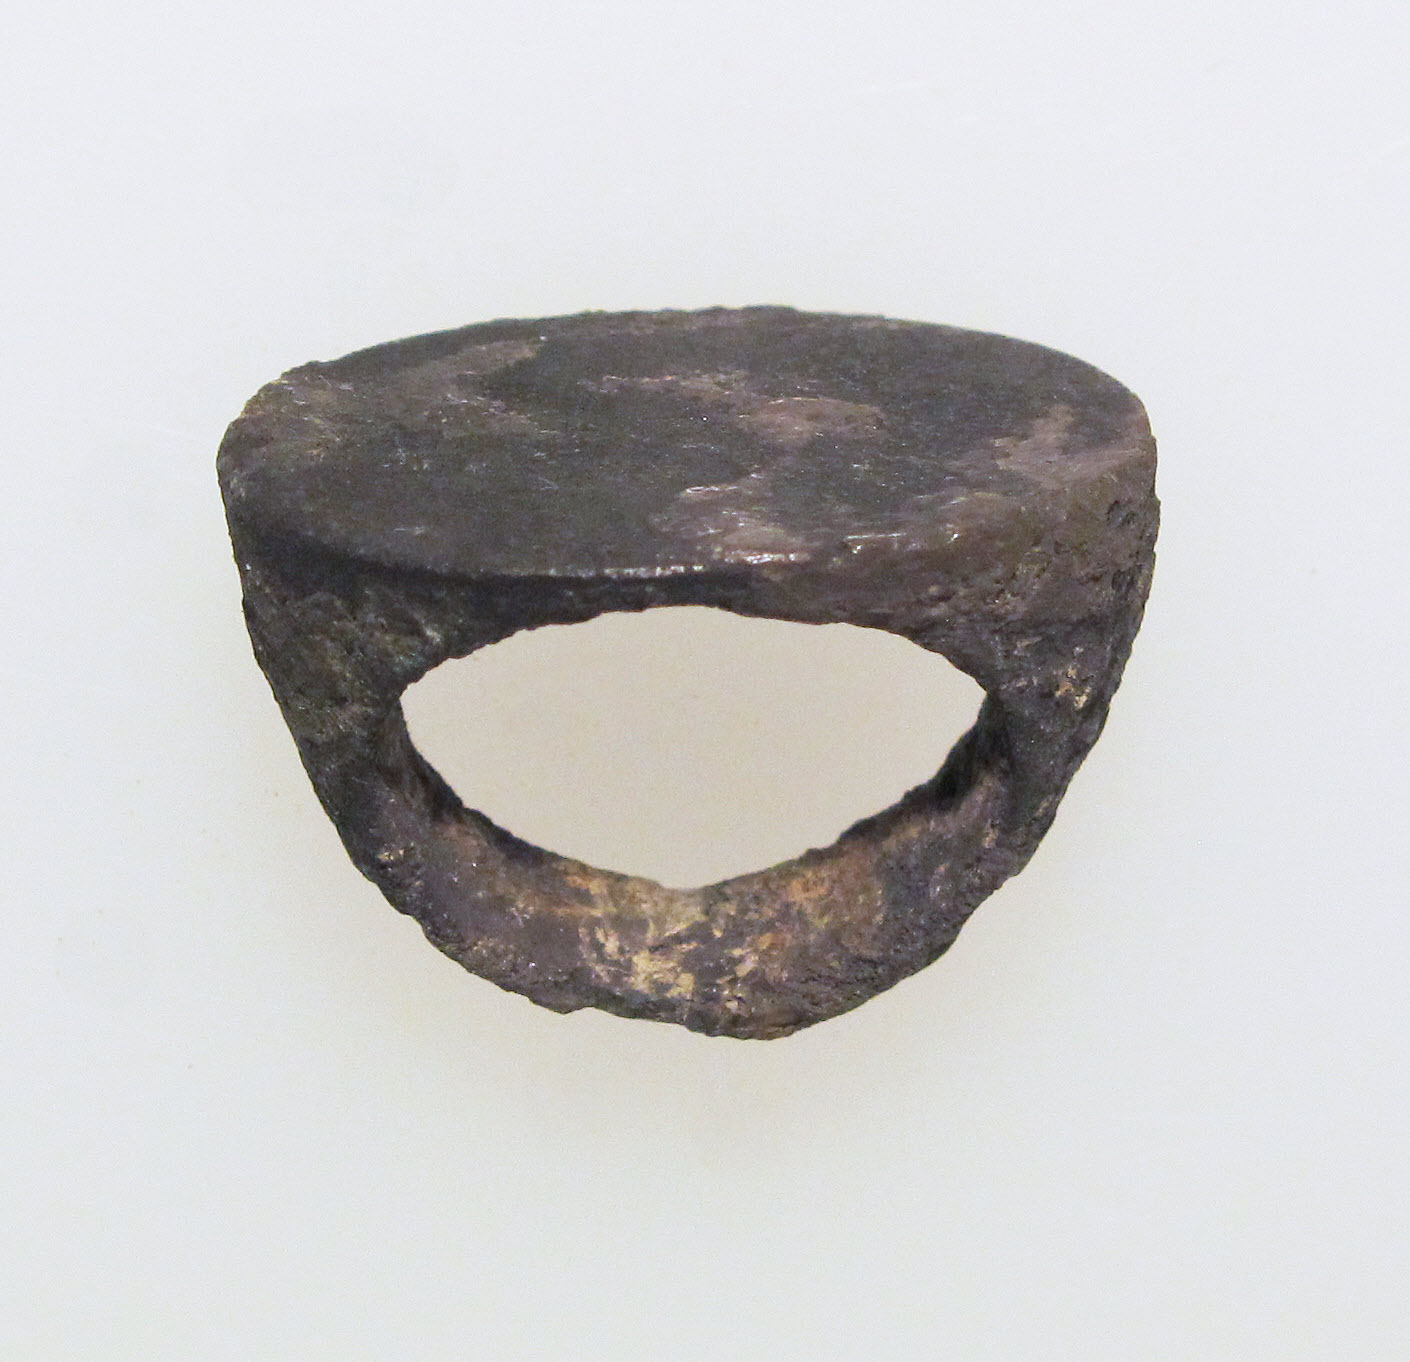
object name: ring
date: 7000 BCE-330 CE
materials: silver